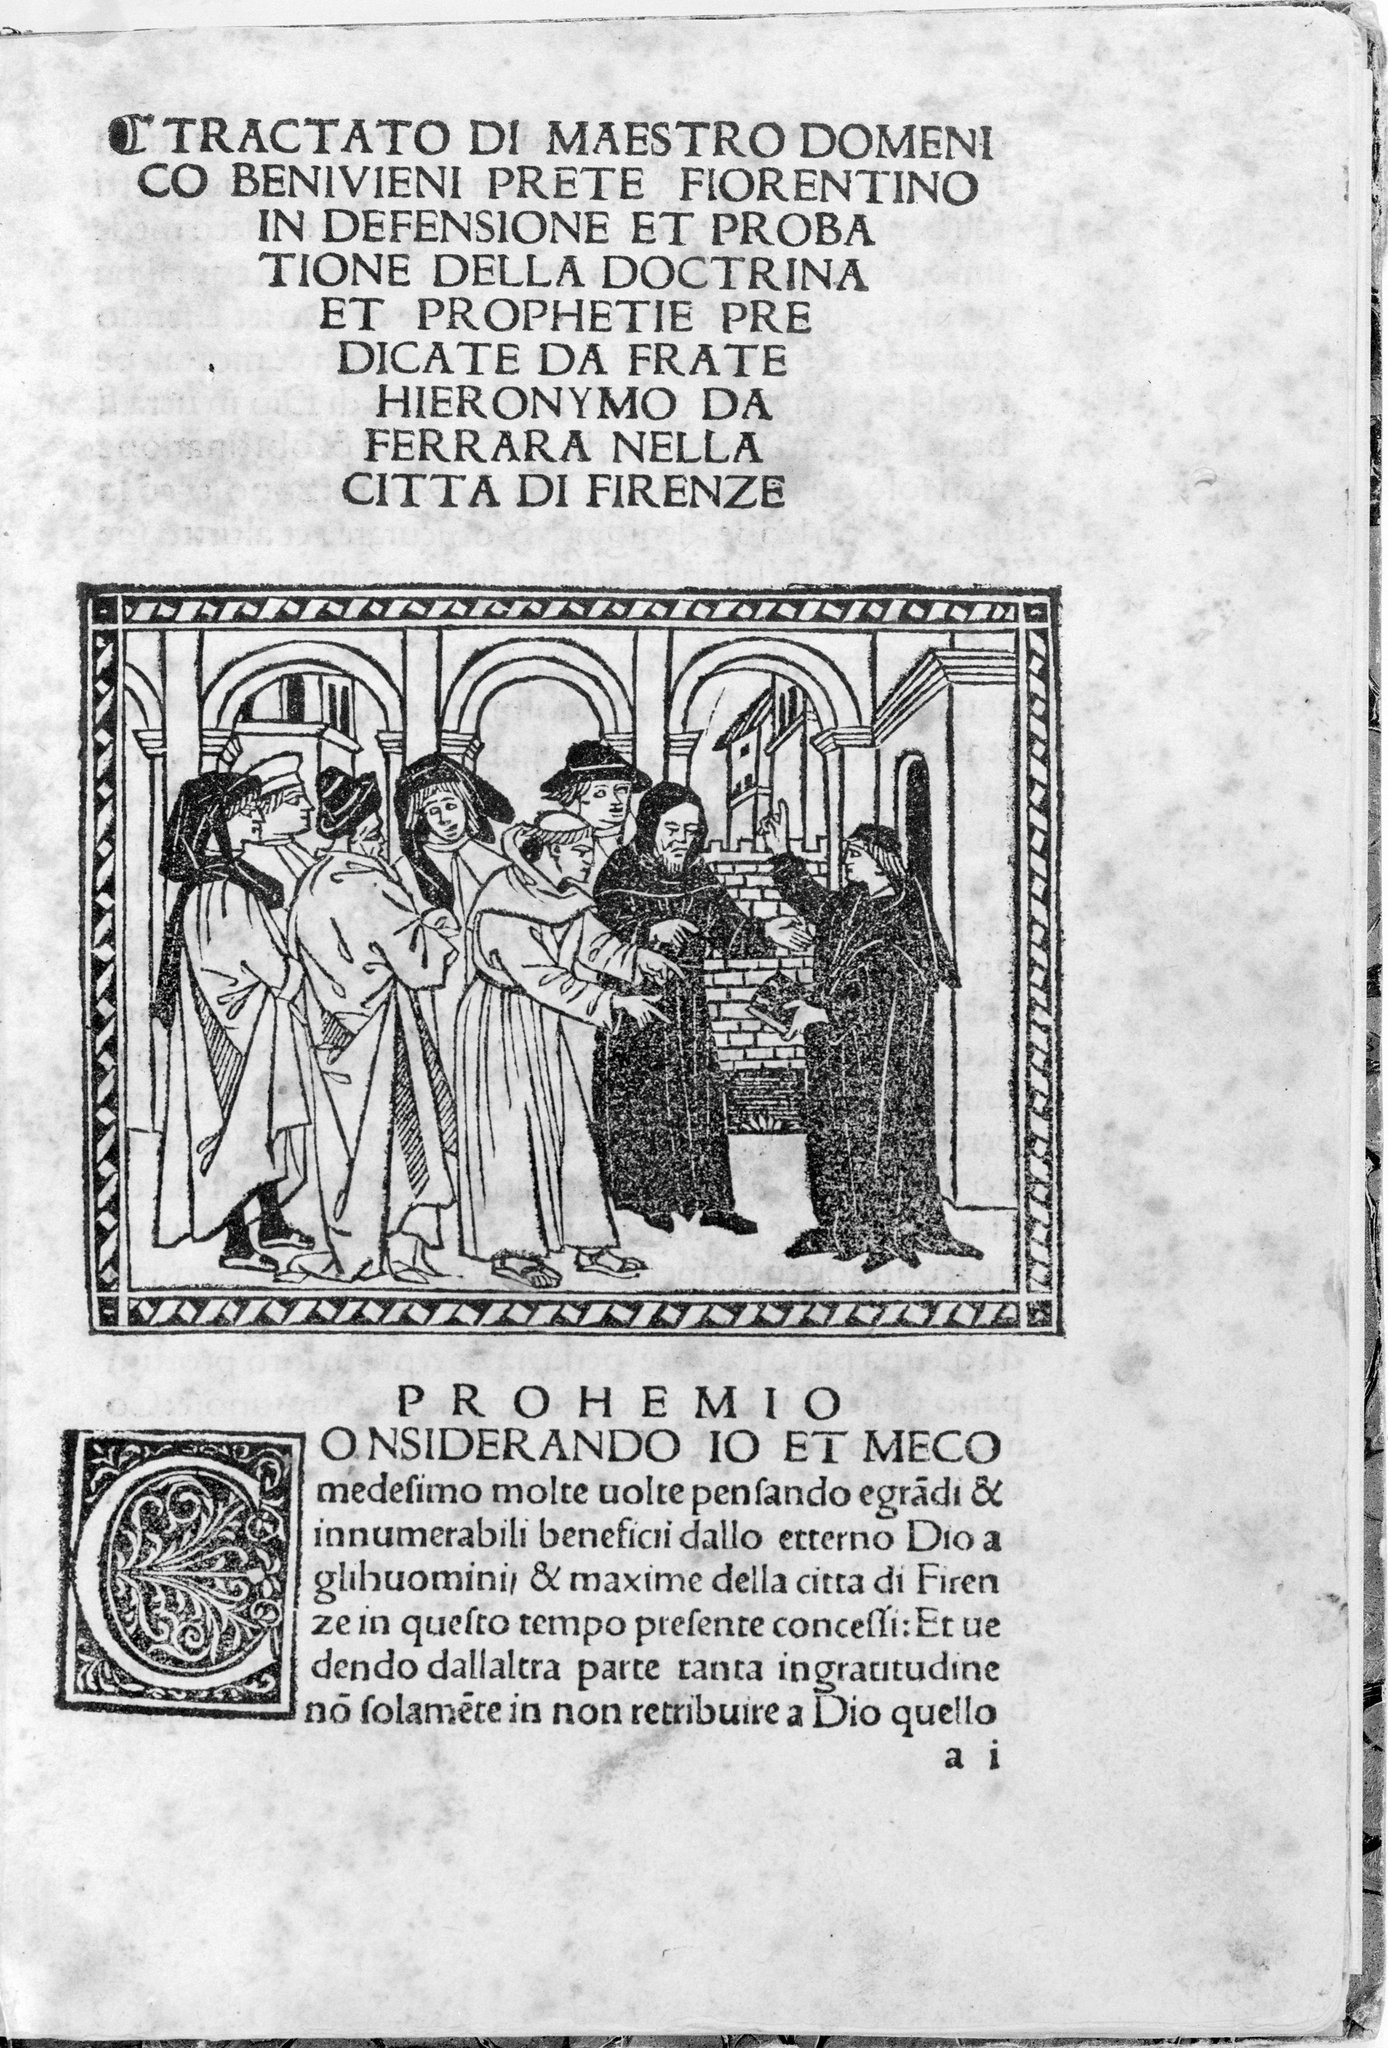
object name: book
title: Tractato in Defensione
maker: domenico benevieni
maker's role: author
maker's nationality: italian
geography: italy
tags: men,women